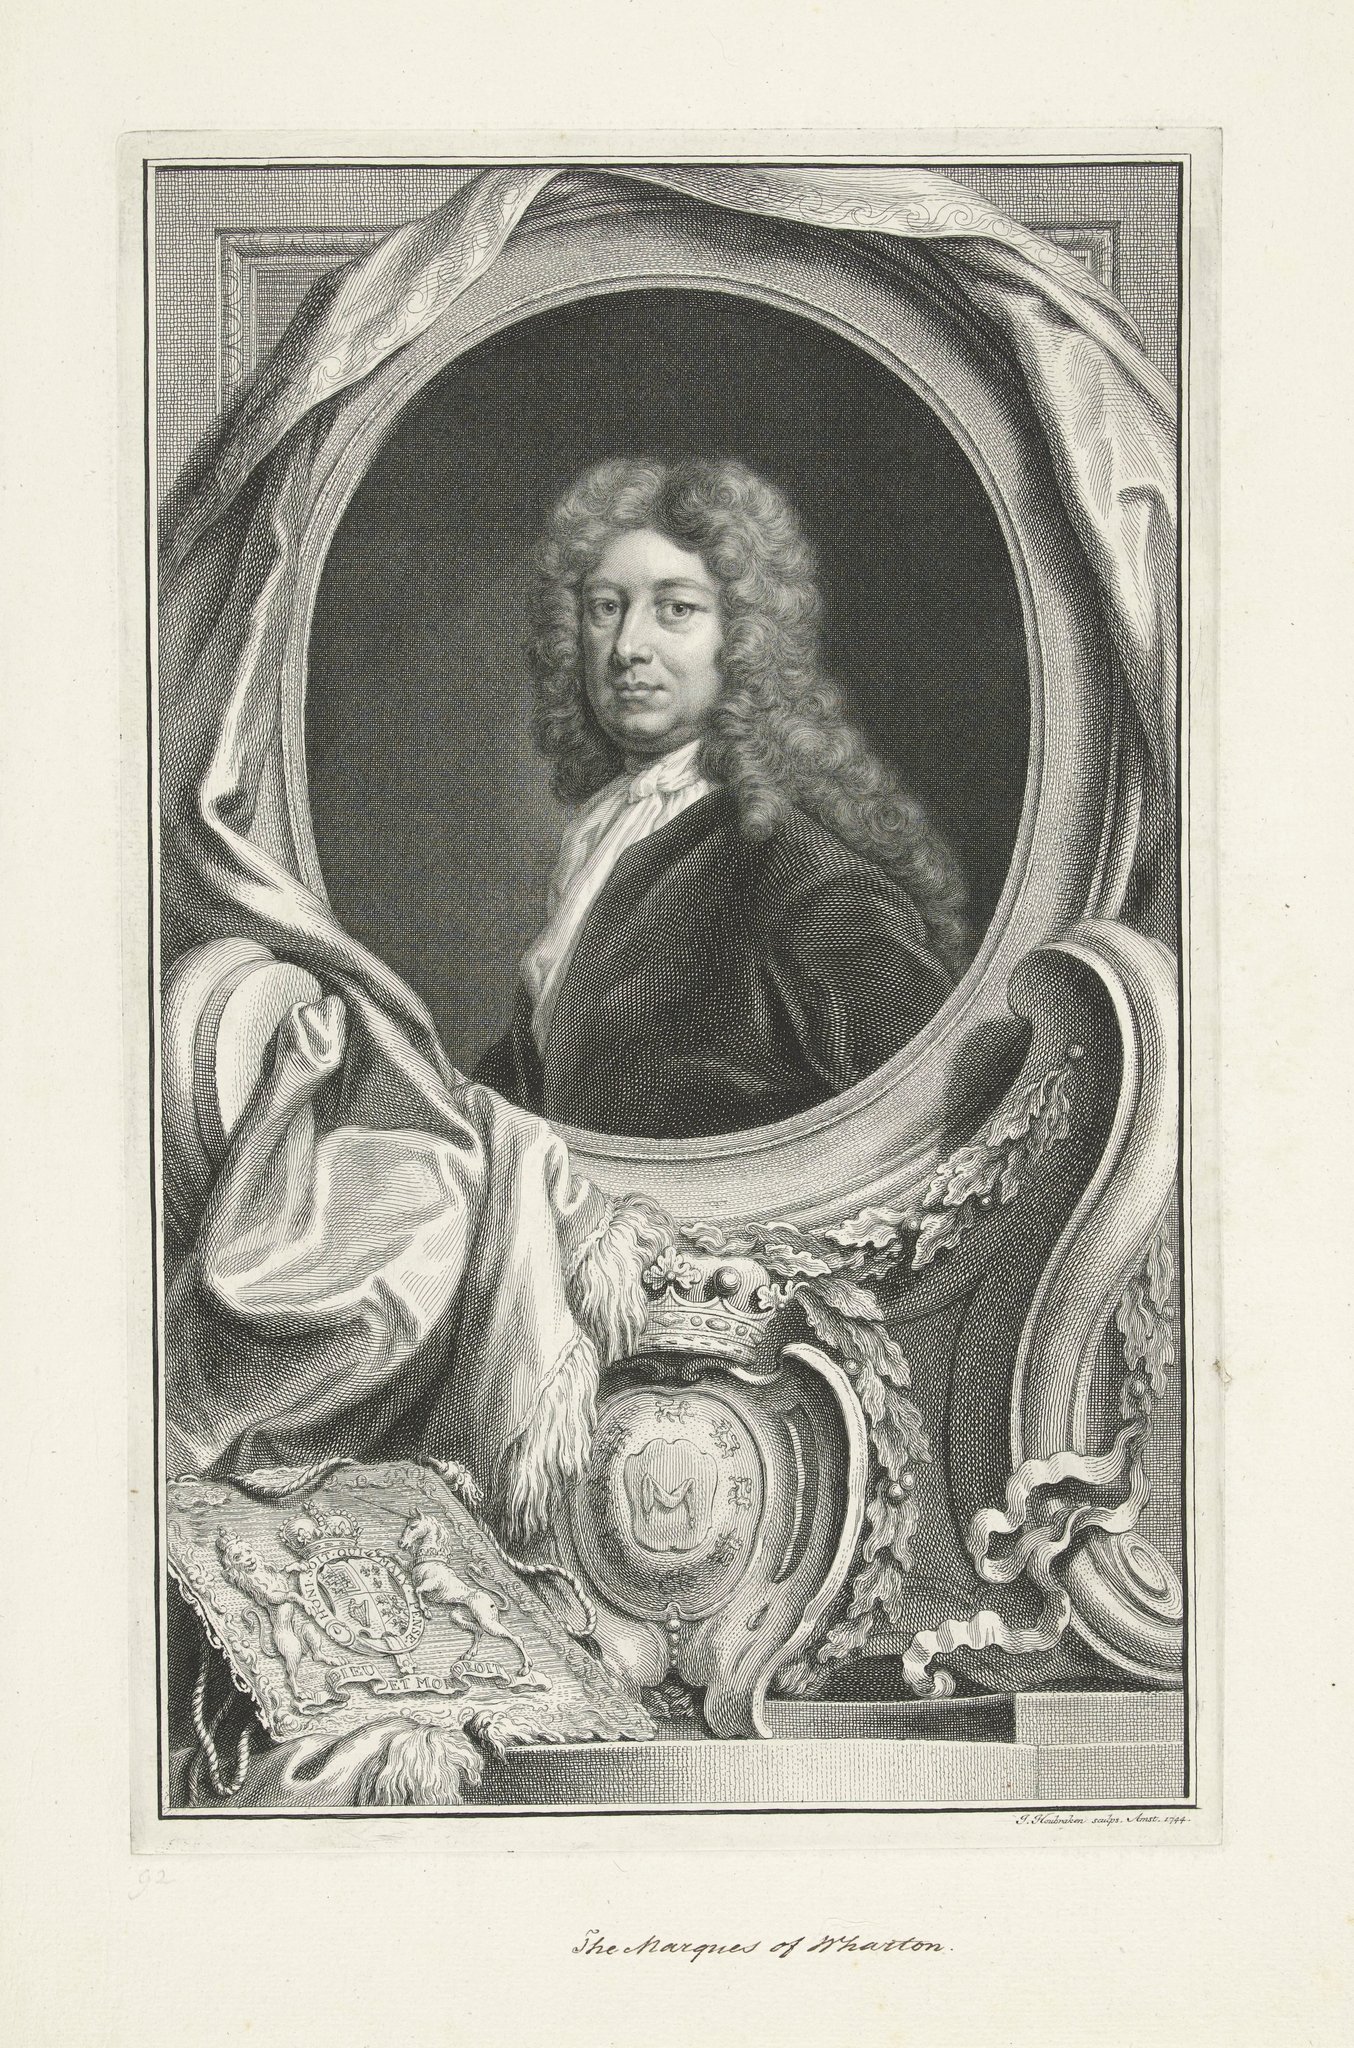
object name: print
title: Portret van Thomas Wharton, markies van Wharton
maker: jacob houbraken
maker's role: draughtsman, print maker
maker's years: 1698-1780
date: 1744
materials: paper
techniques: engraving, etching, pen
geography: amsterdam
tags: politician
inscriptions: name: ‘The Marques of Wharton’, collector's mark: Lugt 240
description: Prent ook gebruikt in: Thomas Birch. The heads of illustrious persons of Great Britain : engraved by Houbraken, and Vertue, with their lives and characters. London: John en Paul Knapton, 1743-1751.